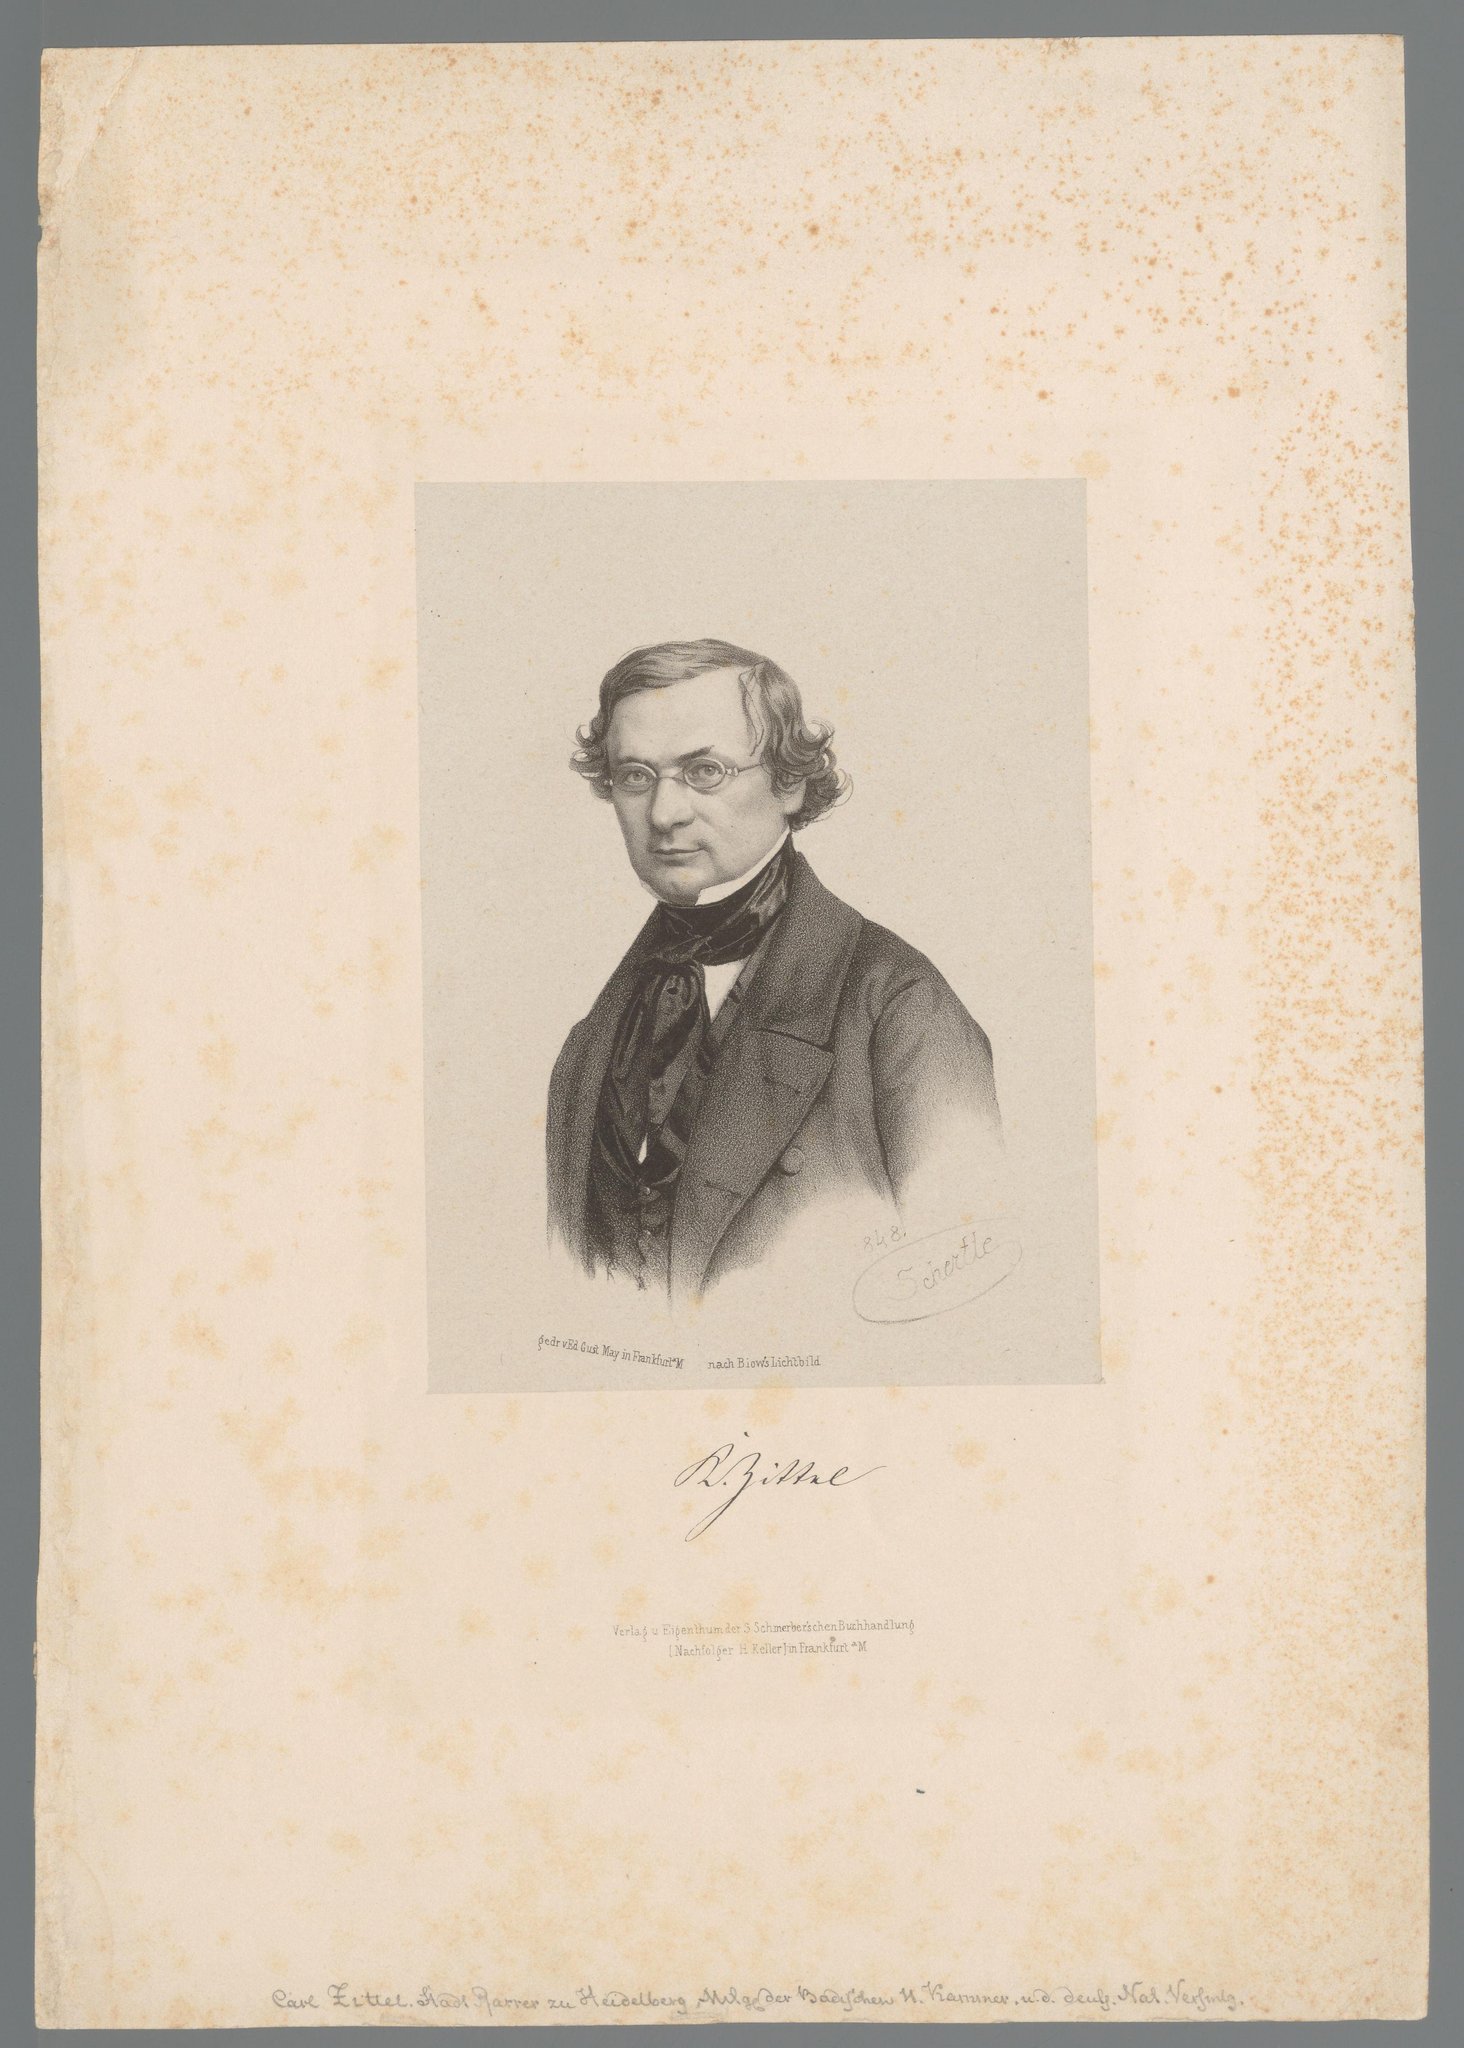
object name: print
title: Die Männer des deutschen Volks, besonders nach Biows Lichtbildern auf Stein gezeichnet von Schertle und Hickmann, oder Deutsche National-Gallerie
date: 1848-1849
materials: paper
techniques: lithograph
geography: frankfurt am main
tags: eyeglasses, spectacles, adult man, historical persons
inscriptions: collector's mark: Lugt 2228